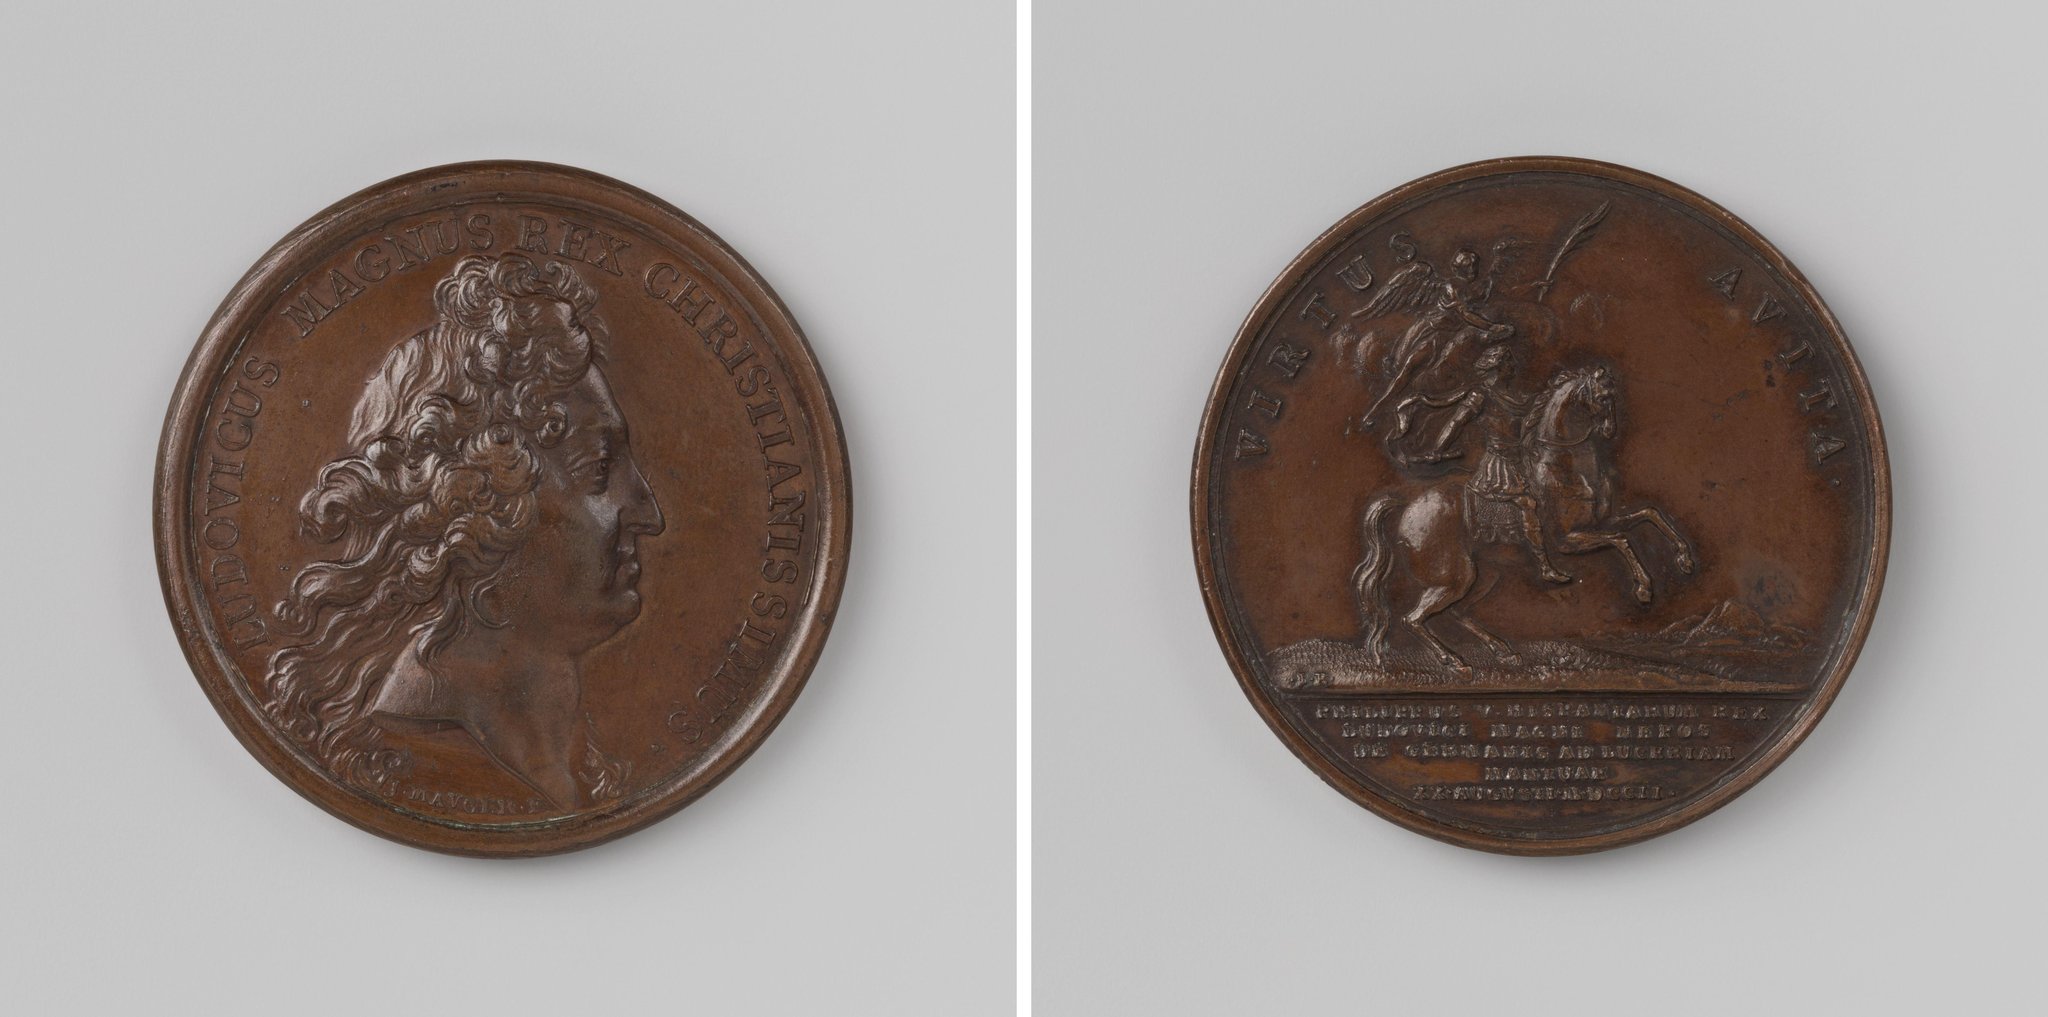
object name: history medal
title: Overwinning van de Fransen en de Spanjaarden bij Luzzara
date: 1699-1703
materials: bronze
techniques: striking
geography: paris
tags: lodewijk xiv (koning van frankrijk), filips v (koning van spanje)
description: Bronzen penning. Voorzijde: borststuk man binnen omschrift. Keerzijde: vliegende Overwinning houdt zegetak en lauwerkrans boven hoofd van Filips V, in Romeinse kledij te paard binnen omschrift, boven opschrift.